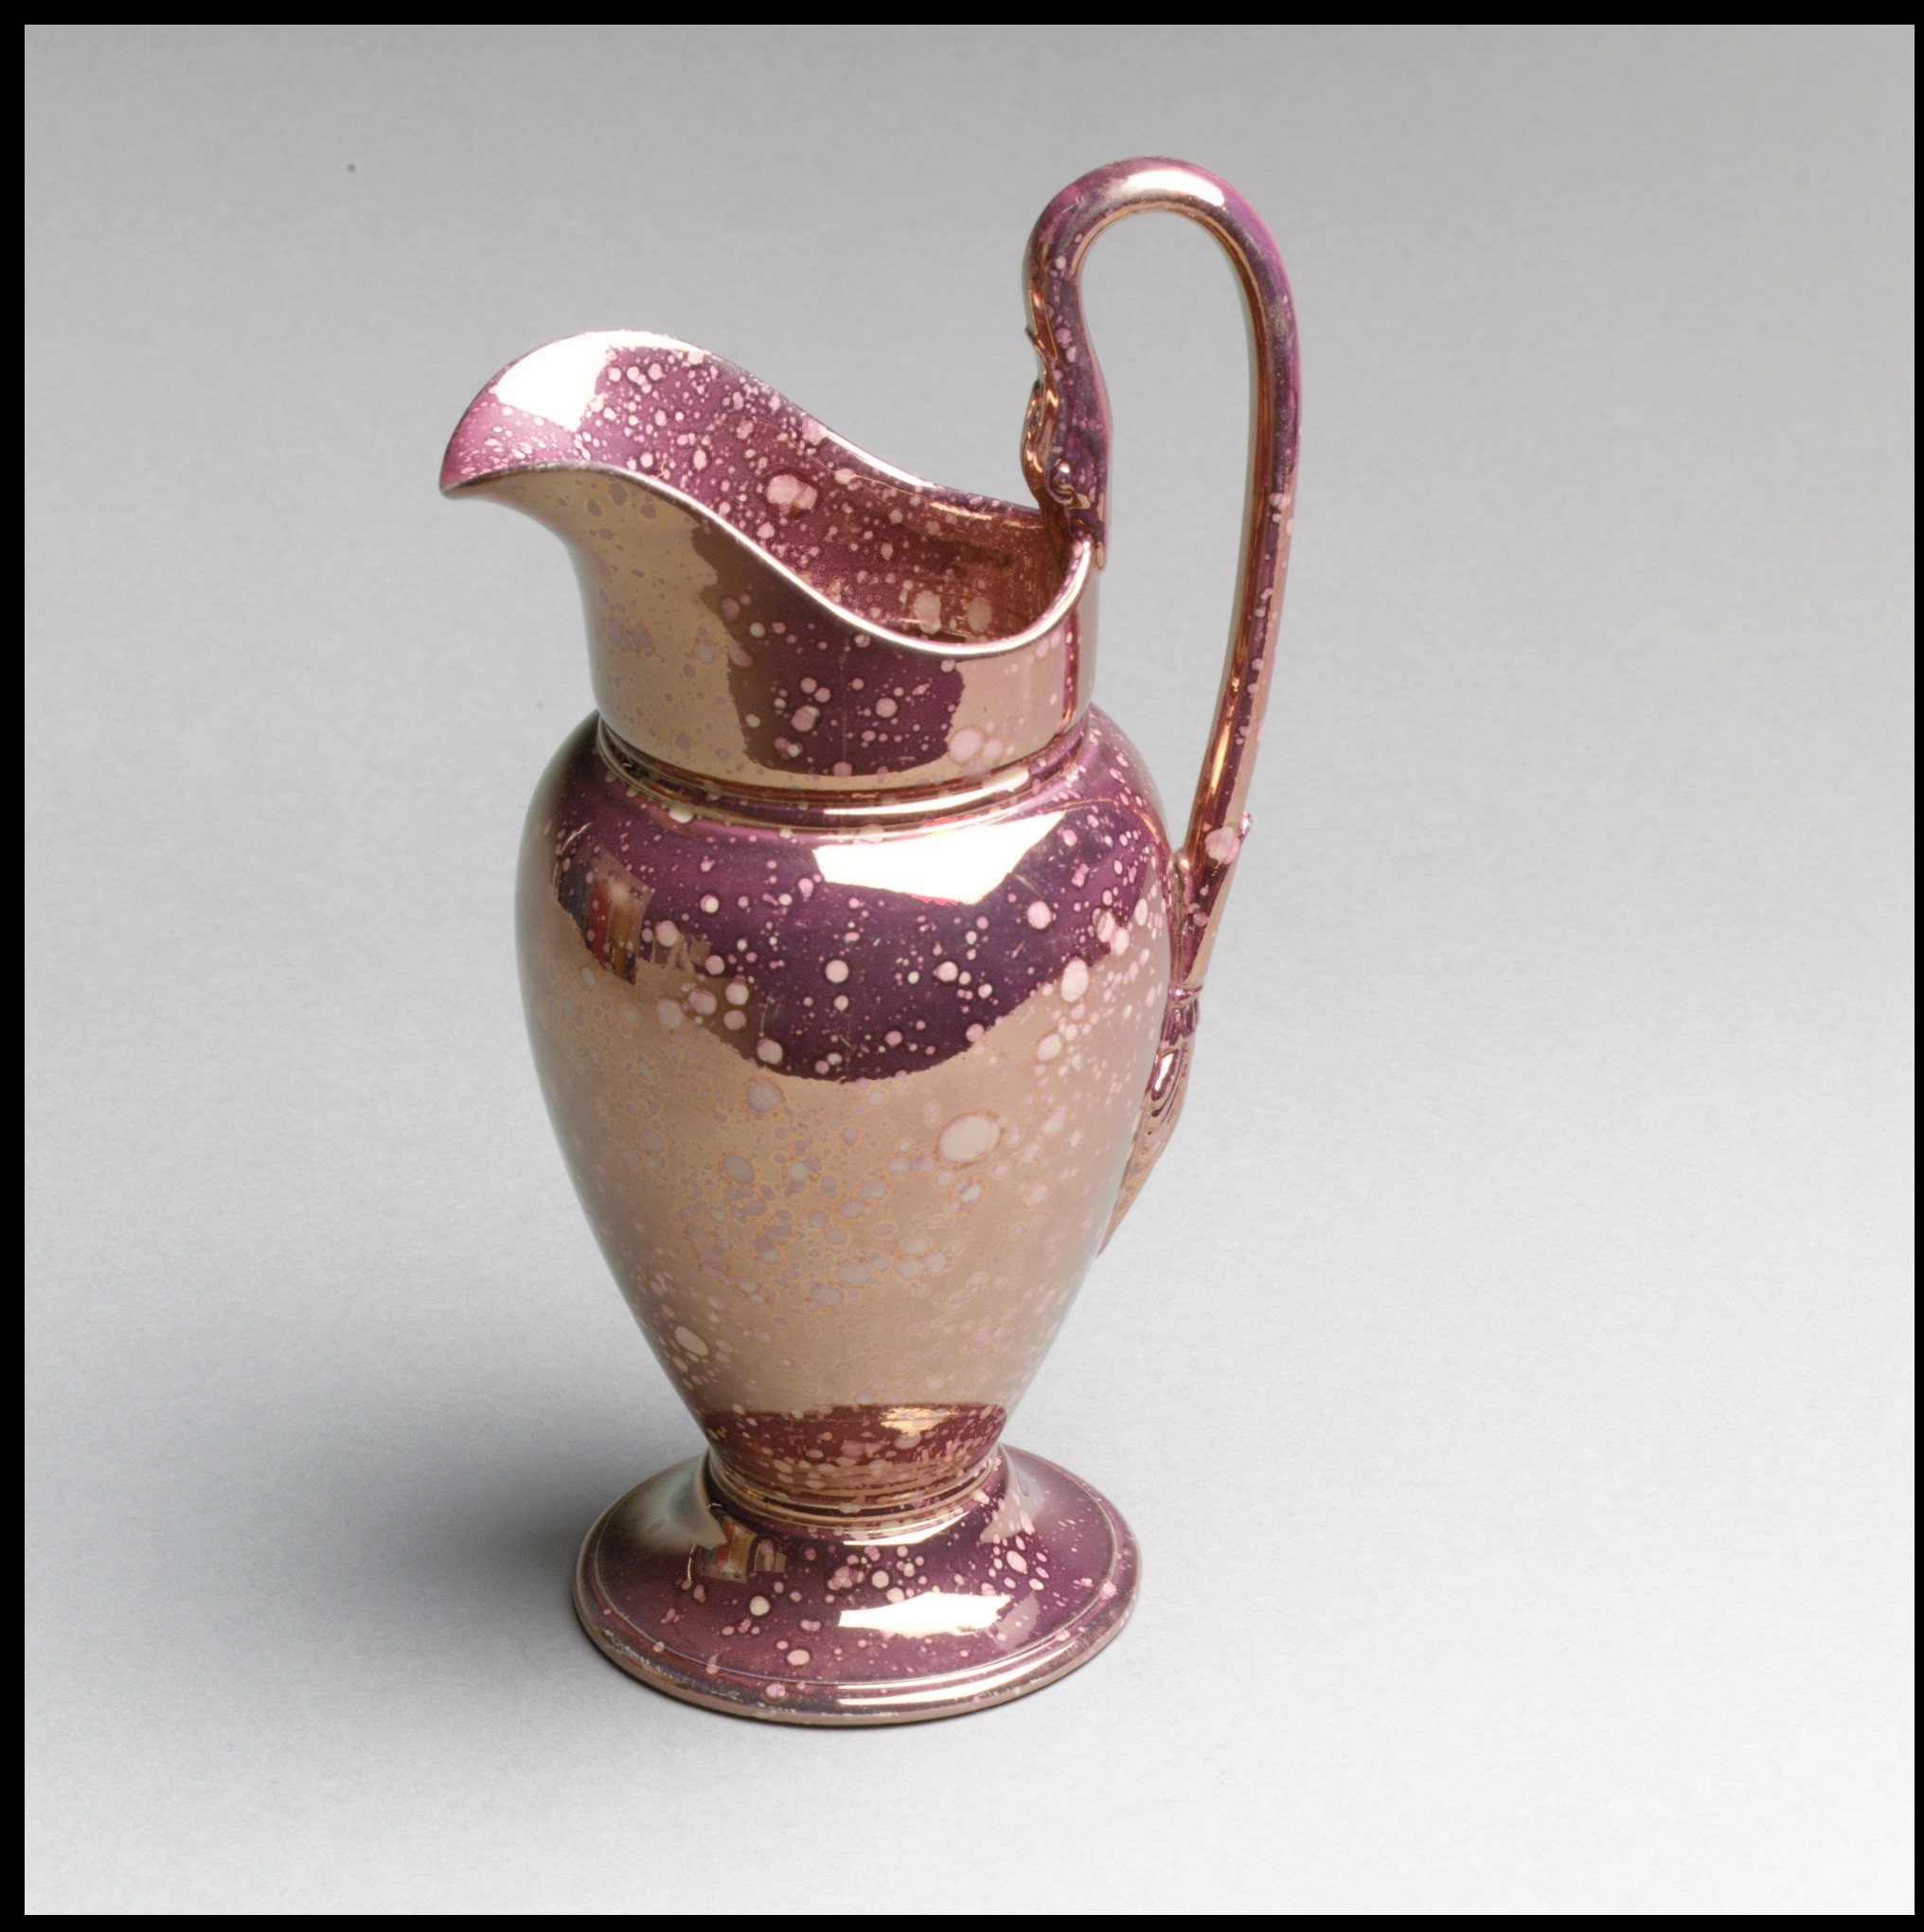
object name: milk jug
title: Milk jug (part of a set)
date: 1810